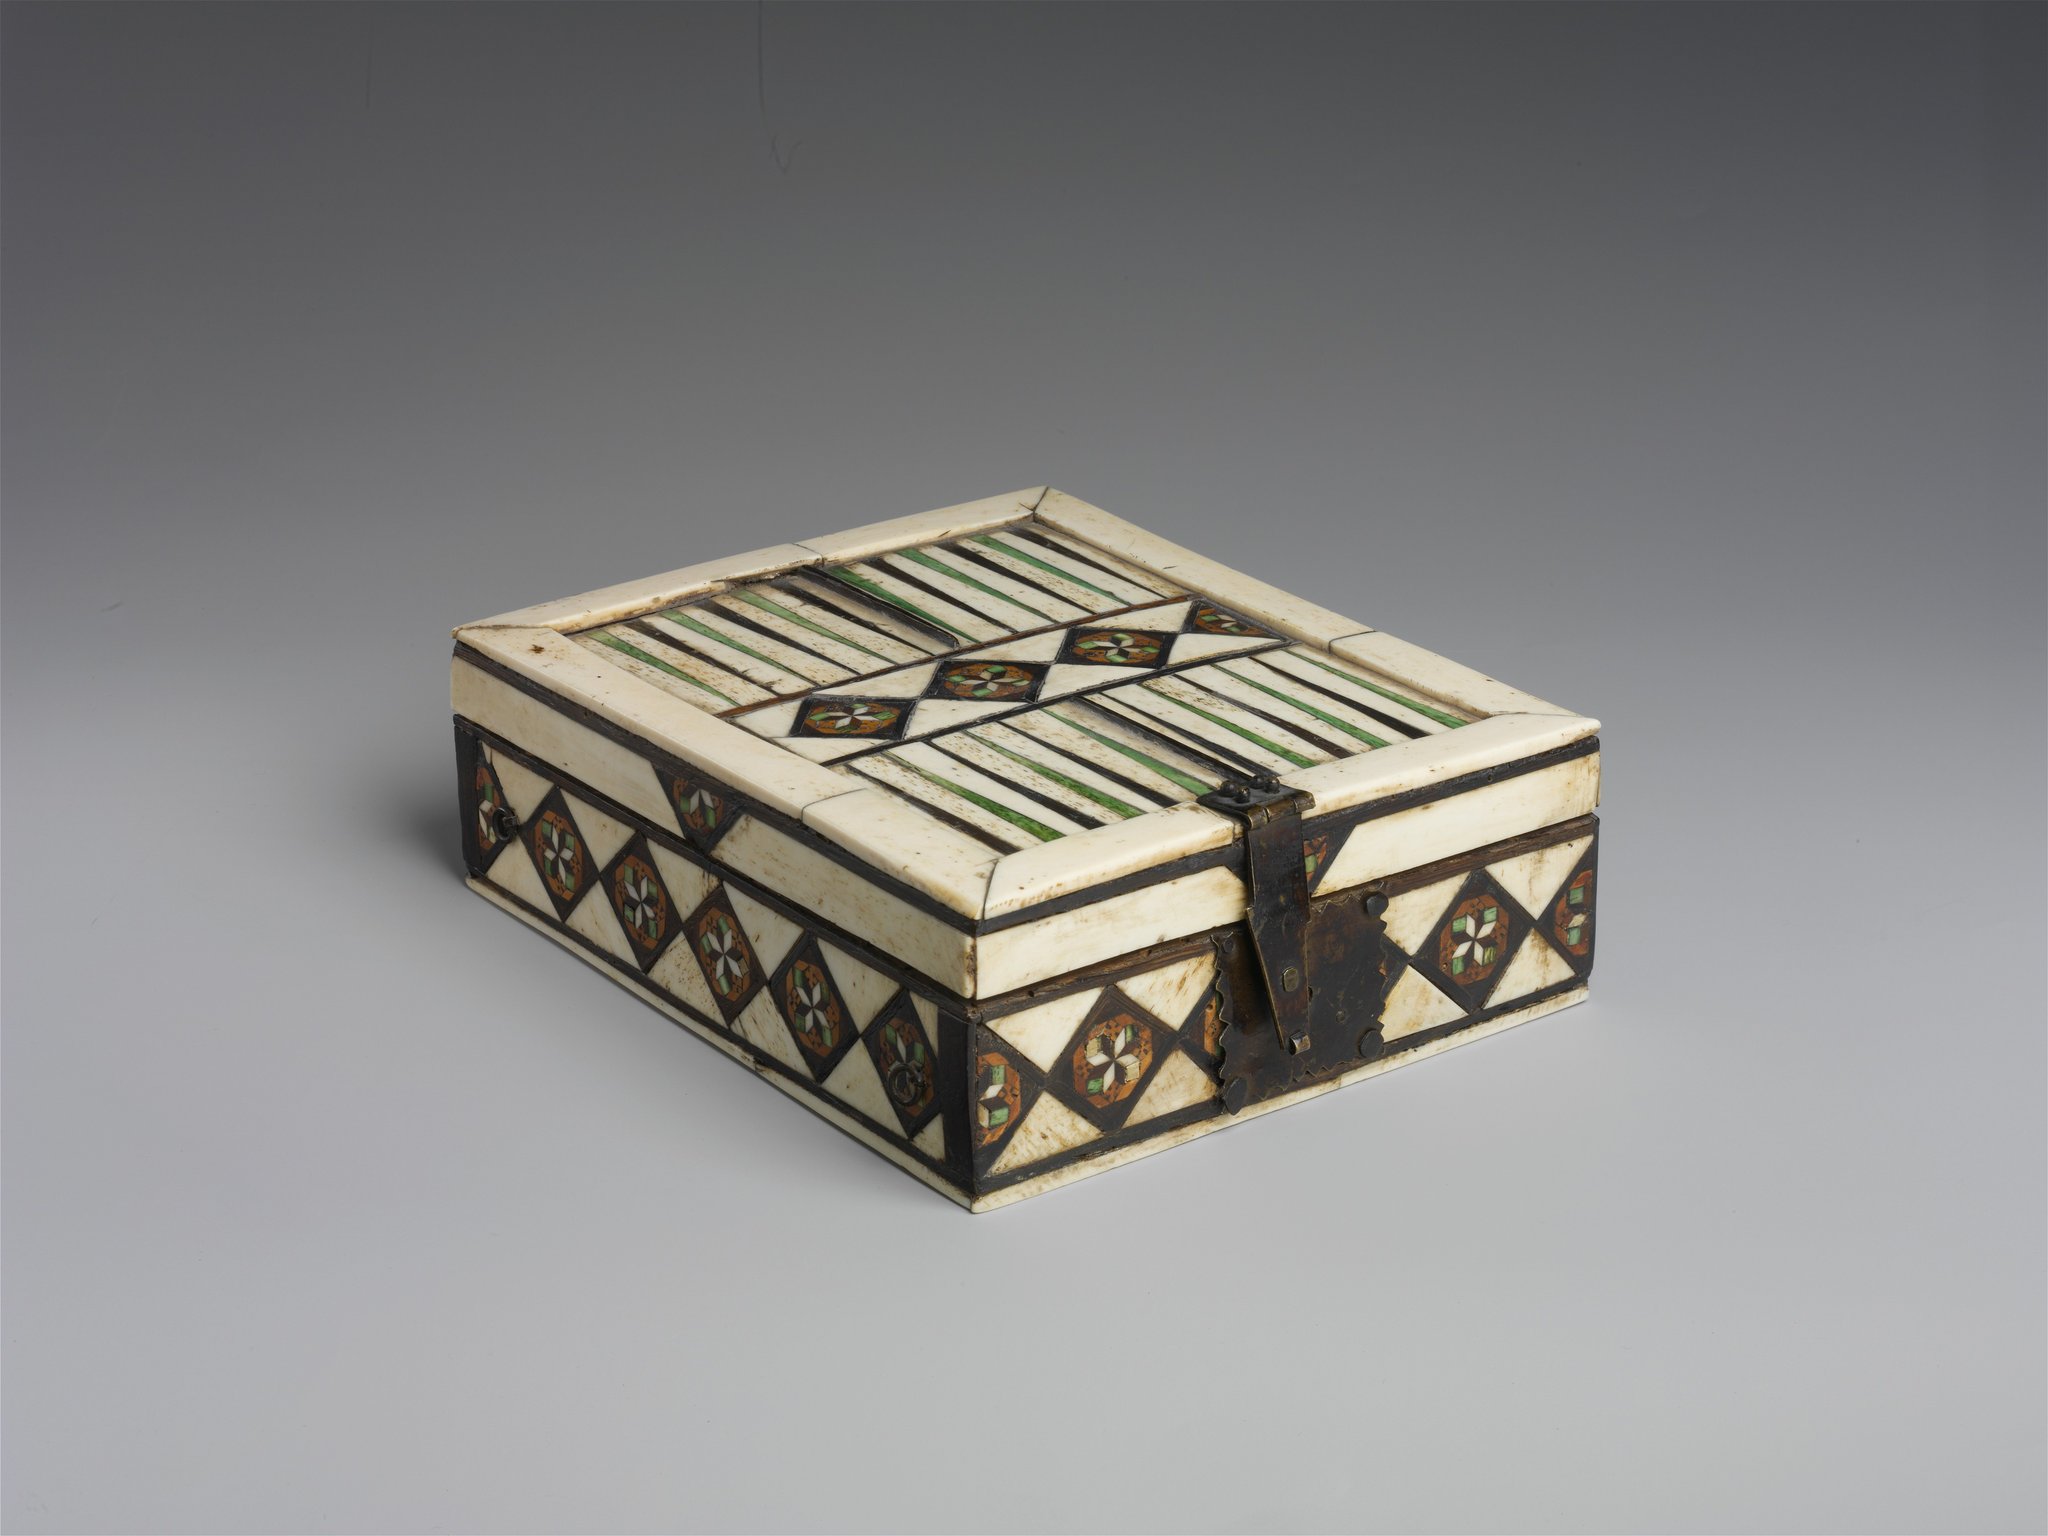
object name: game box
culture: italian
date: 1301-1400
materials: bone, metal, paper, textile, wood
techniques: lining